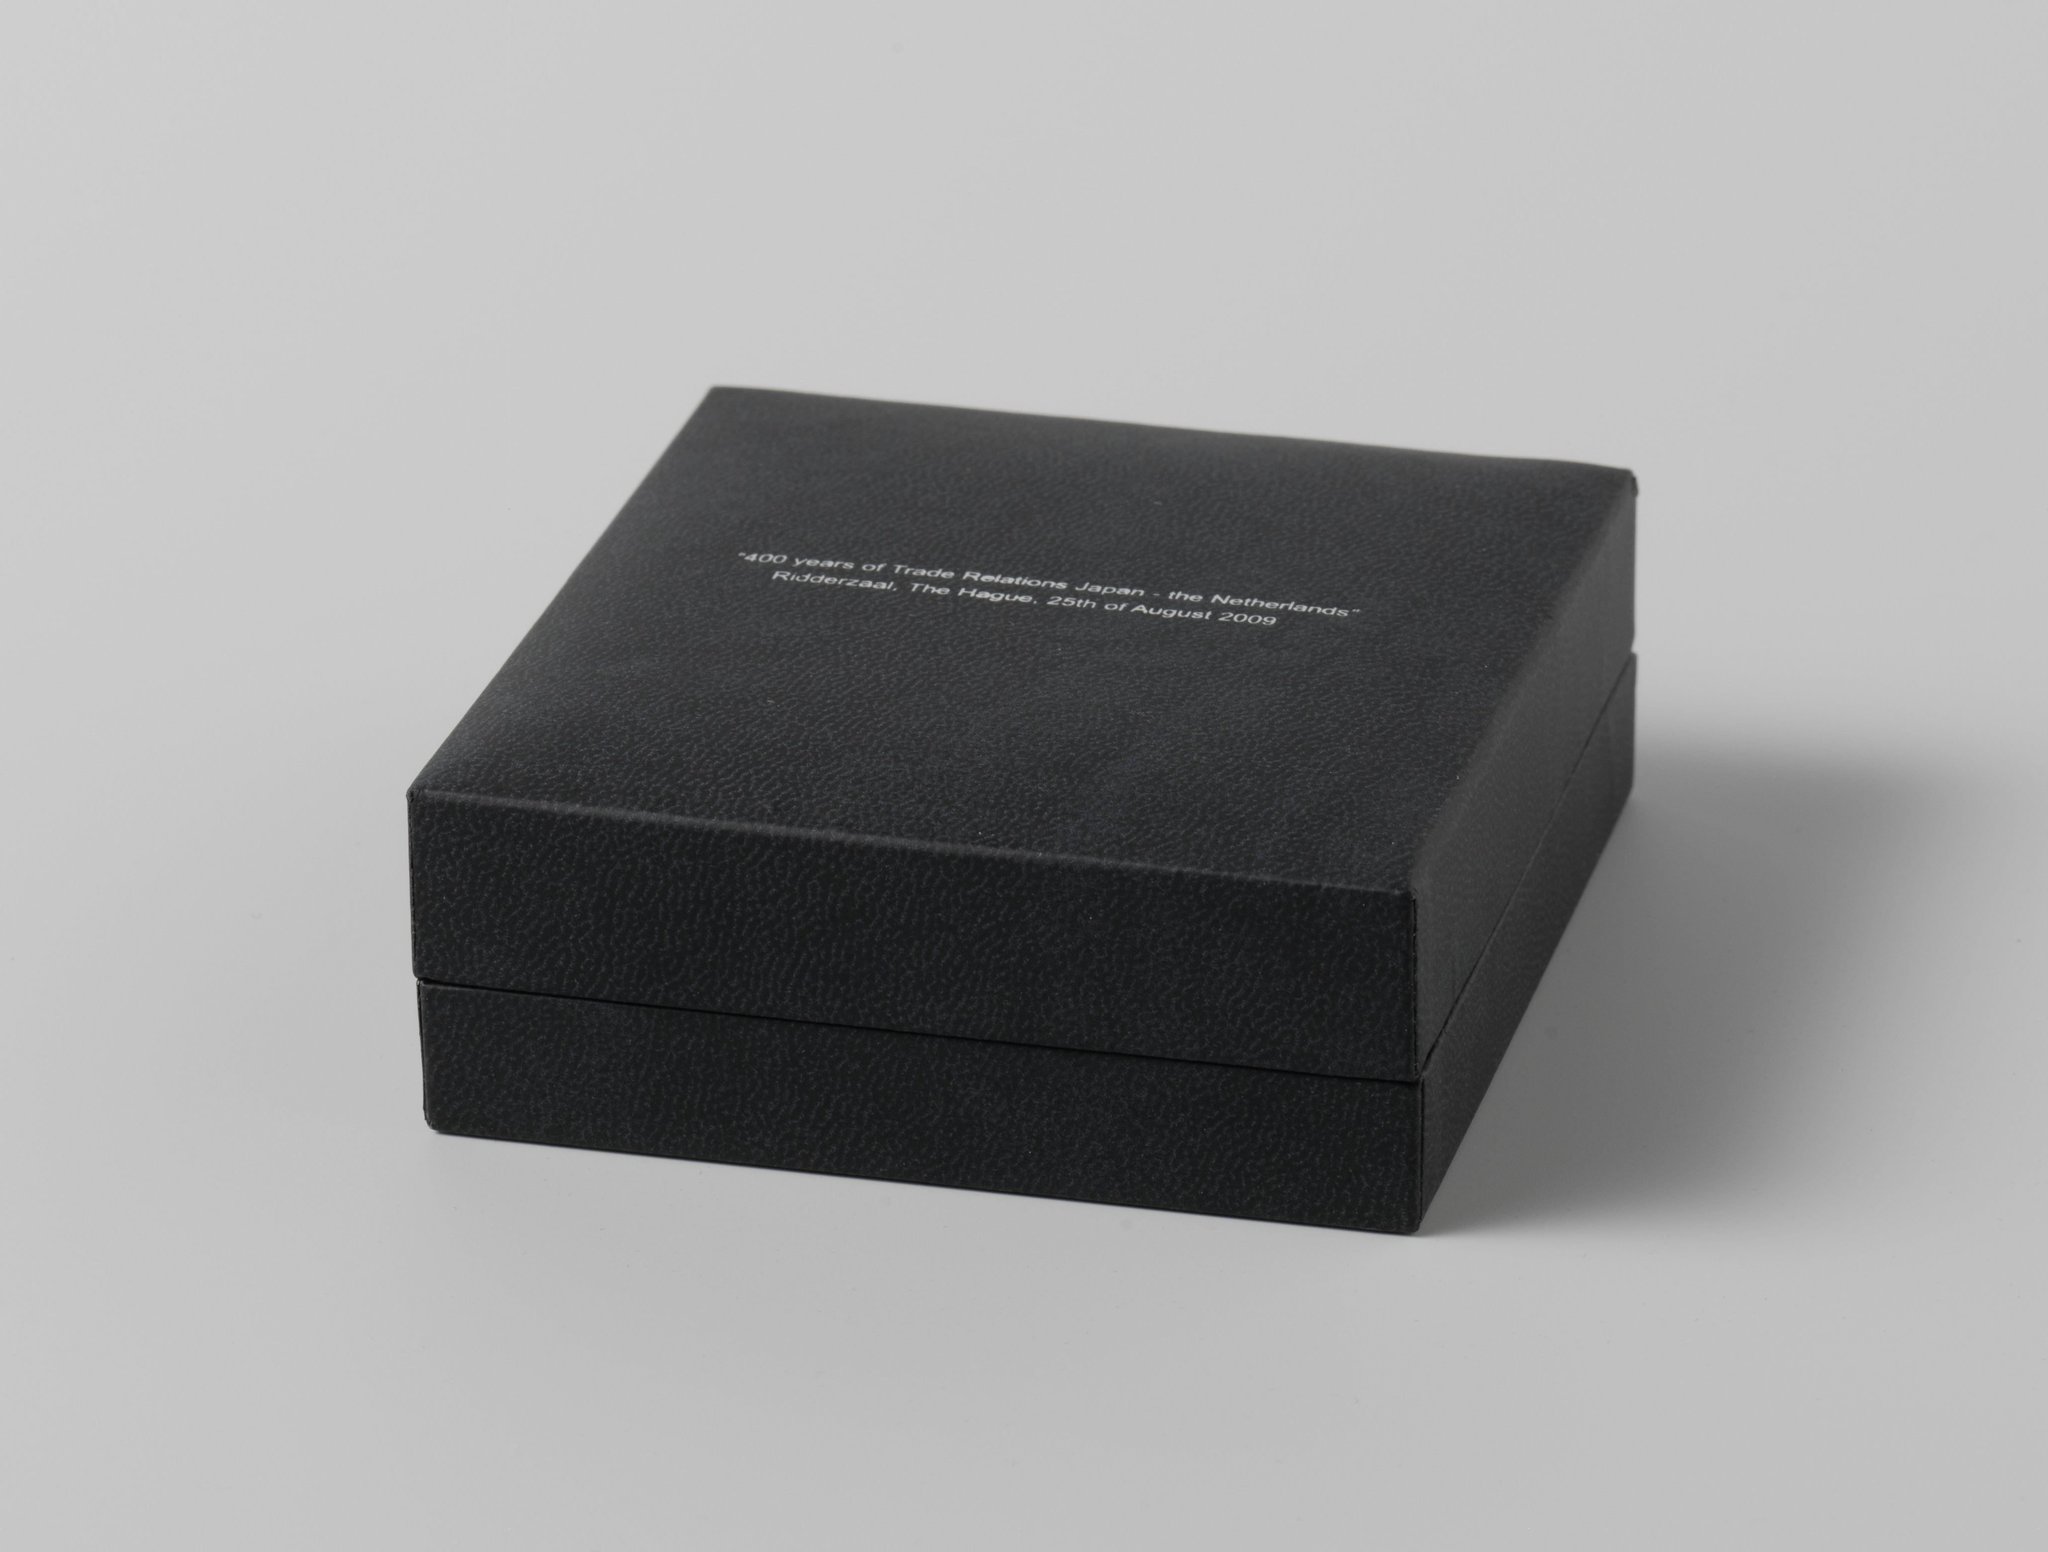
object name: medal box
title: Doosje bij penning en munt 400 jaar handelsbetrekkingen Nederland-Japan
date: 2009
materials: leather, paper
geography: utrecht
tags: netherlands, japan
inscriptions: inscription: ‘400 years of Trade Relations Japan - the Netherlands Ridderzaal, The Hague, 25th of August 2009’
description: Met zwart leer bekleed doosje met los deksel voor penning en munt ter gelegenheid van 400 jaar handelsbetrekkingen tussen Japan en Nederland. Hierin een gedrukt vouwblad met informatie over penning, munt en de aanleiding. Opschrift op de deksel van de doos: "400 years of Trade Relations Japan - the Netherlands" Ridderzaal, The Hague, 25th of August 2009.